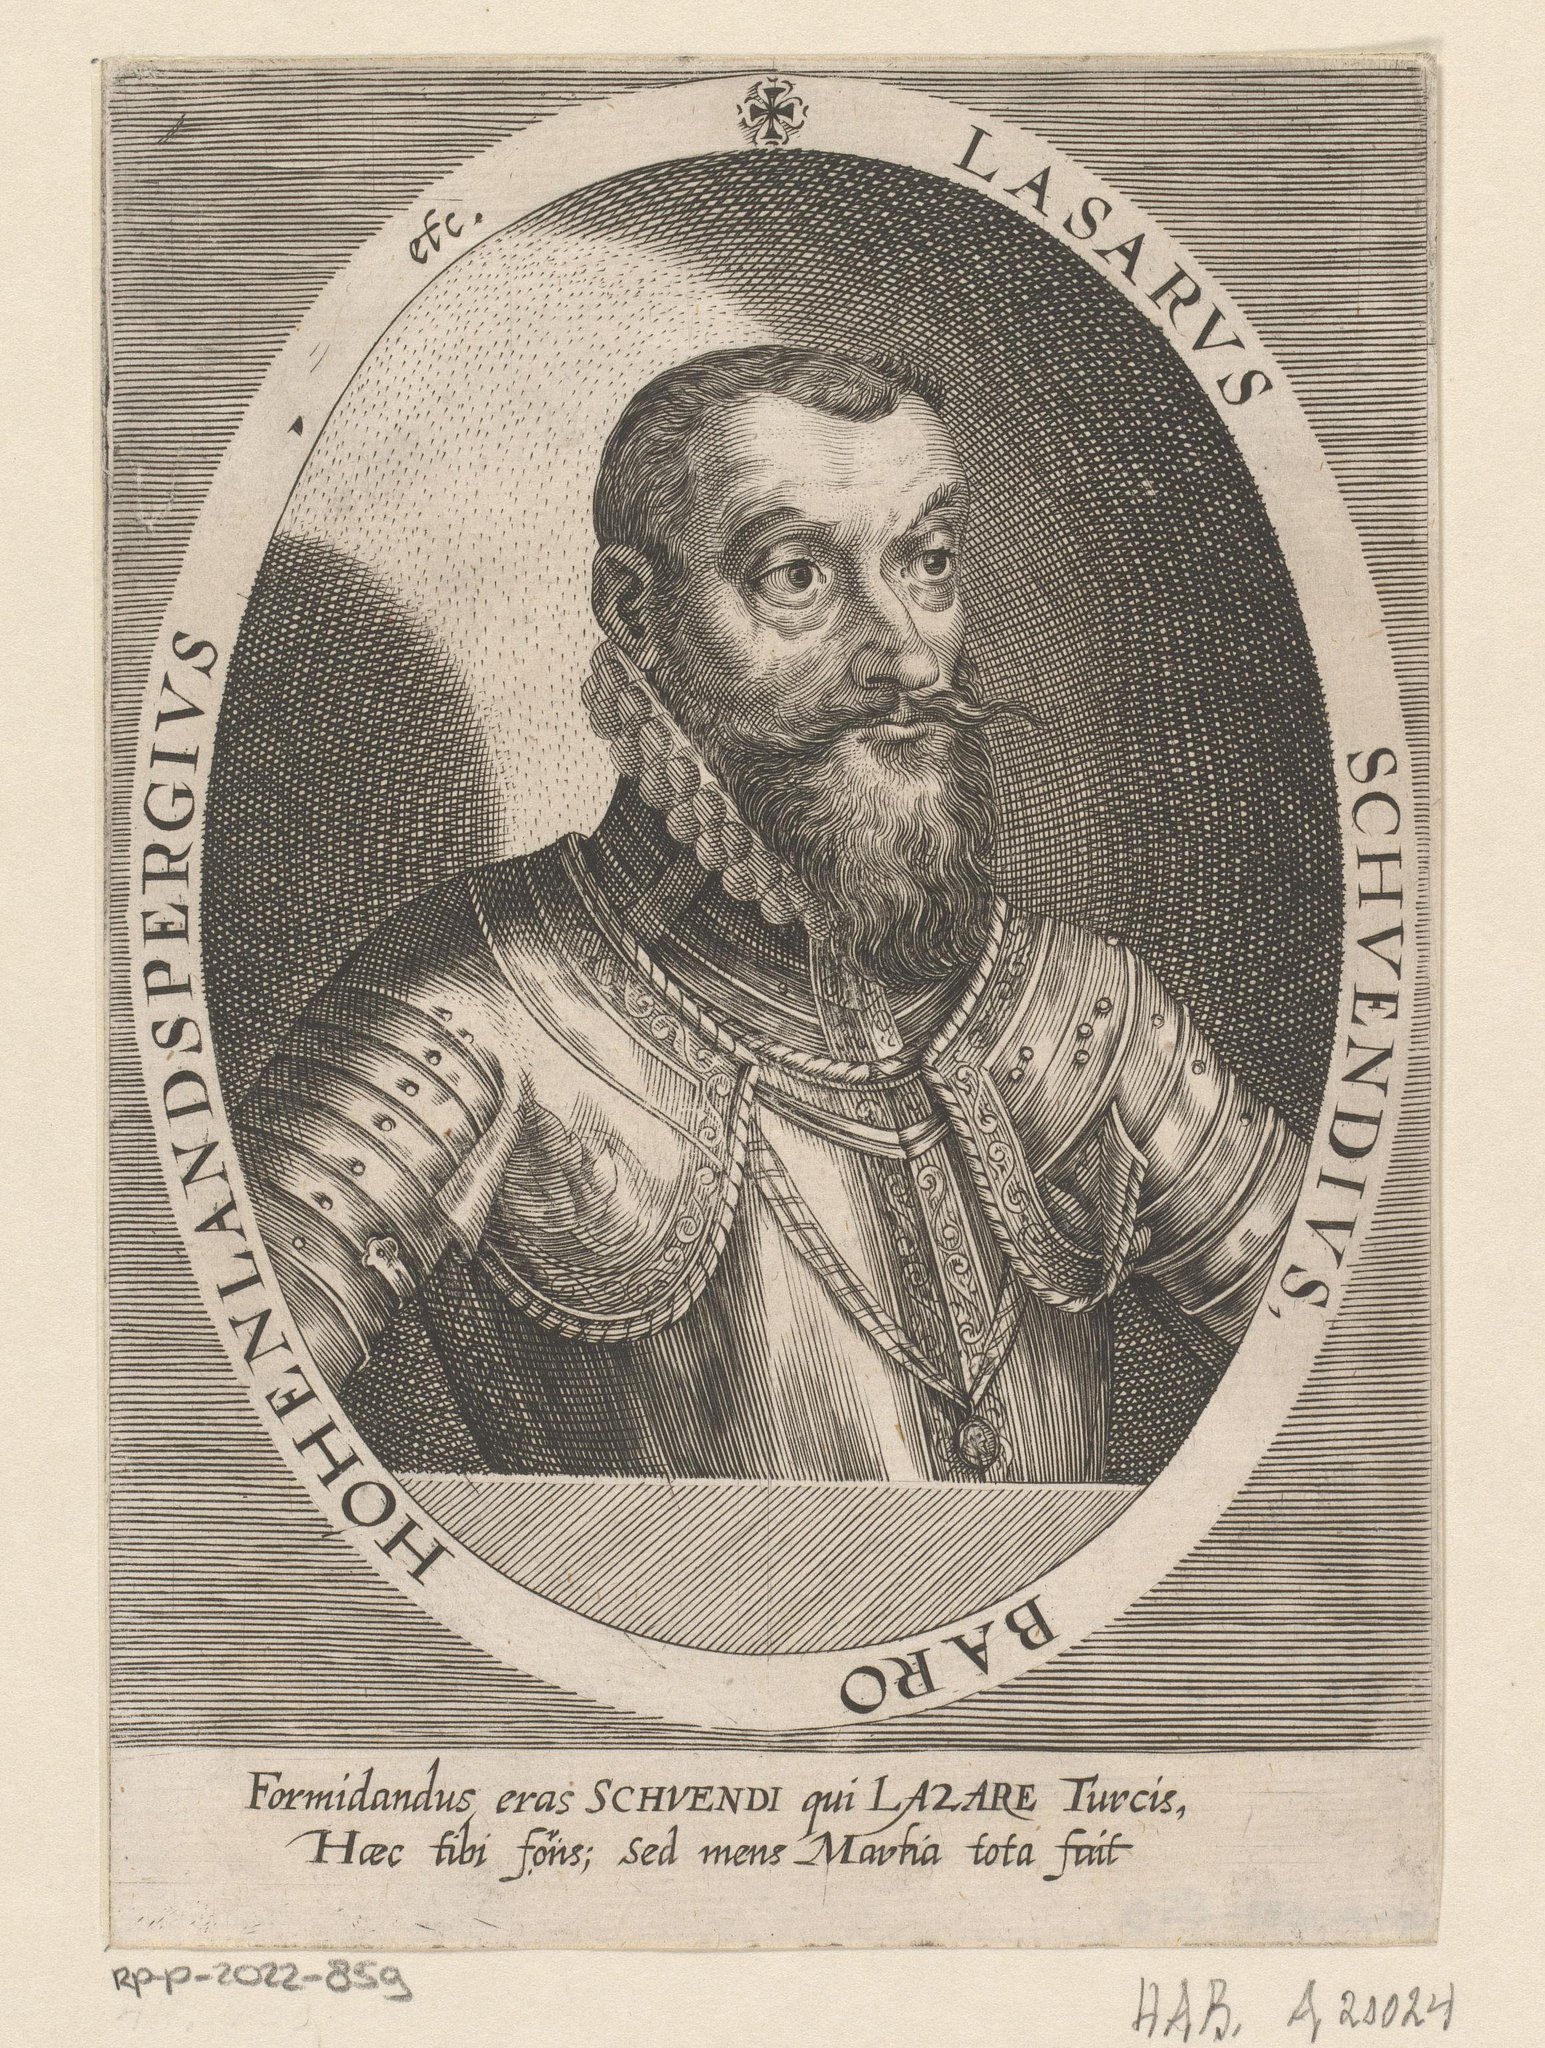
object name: print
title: Atrium Heroicum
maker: dominicus custos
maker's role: print maker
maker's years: 1560-1615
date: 1601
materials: paper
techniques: engraving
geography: augsburg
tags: historical persons, politician, e.g. party leader, diplomacy, diplomat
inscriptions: collector's mark: Lugt 2228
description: Prent waarschijnlijk uit: Custos, Dominicus. Atrium heroicum caesarum (...). Augsburg: Dominicus Custos, 1601, dl. 3. De serie werd in vier delen uitgegeven tussen 1600 en 1604.